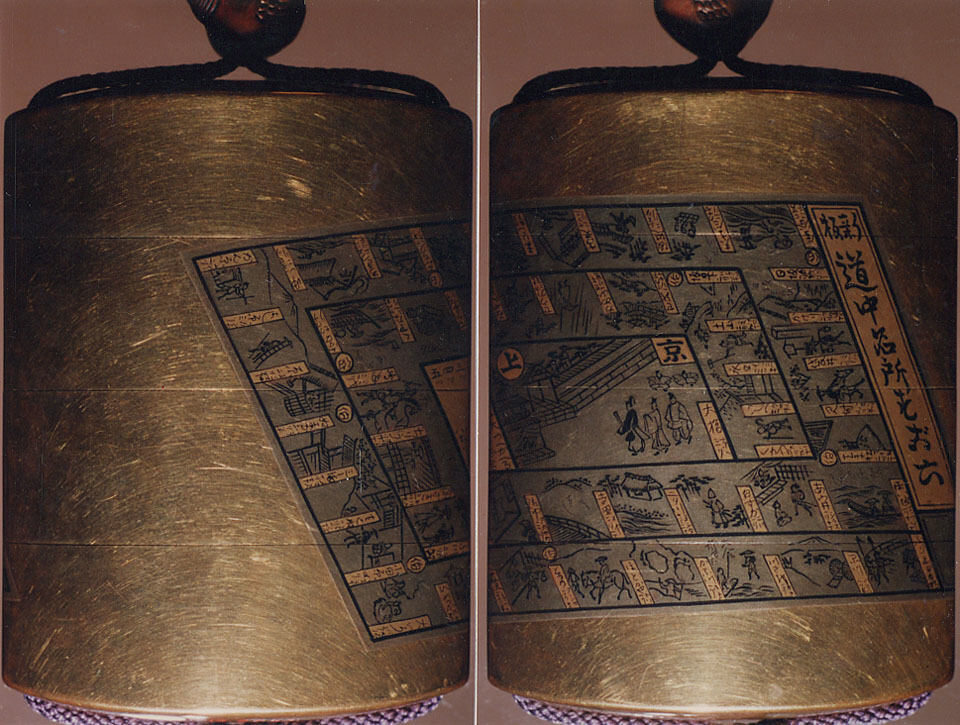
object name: inrō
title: Case (Inrō) with Design of Game Board Showing the Fifty-Three Stations of the Tokaidō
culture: japanese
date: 1801-1900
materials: lacquer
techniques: fundame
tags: games